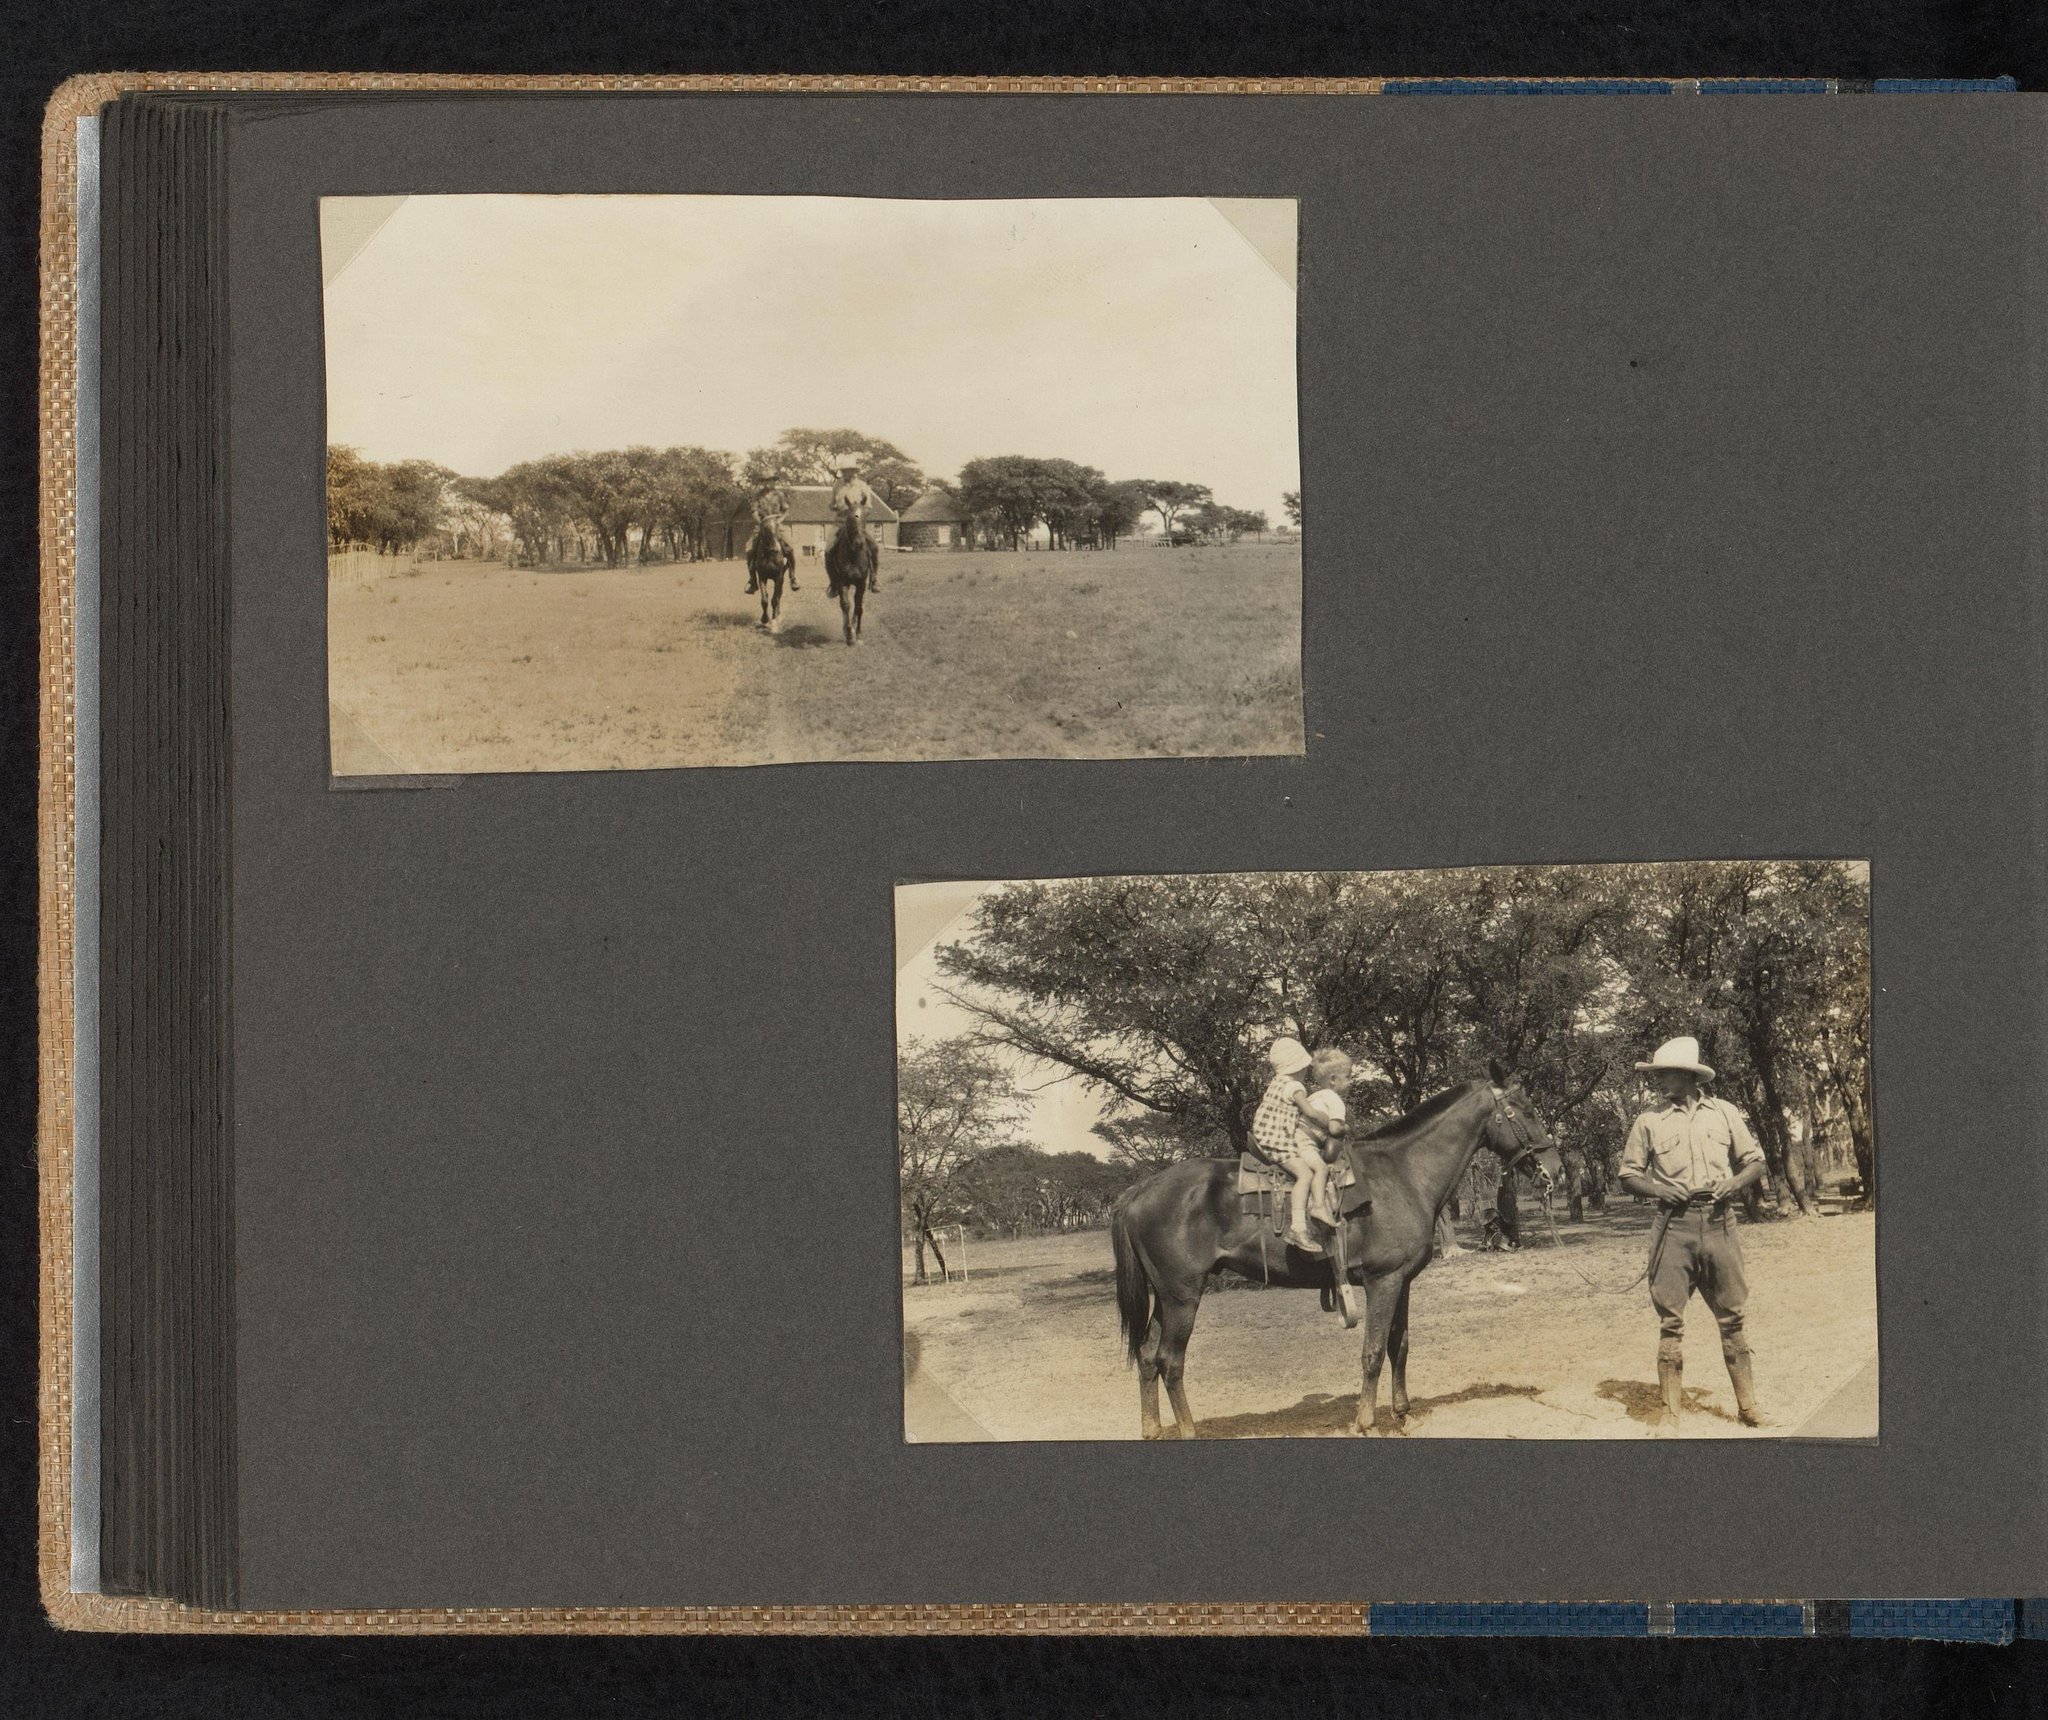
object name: photograph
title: Mannen en kinderen te paard in Zuid-Afrika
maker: karel frederik van den berg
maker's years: 1873-1948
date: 1920-1930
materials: paper, cardboard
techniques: gelatin silver print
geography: south africa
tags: horse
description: Deze foto's zijn onderdeel van een album.